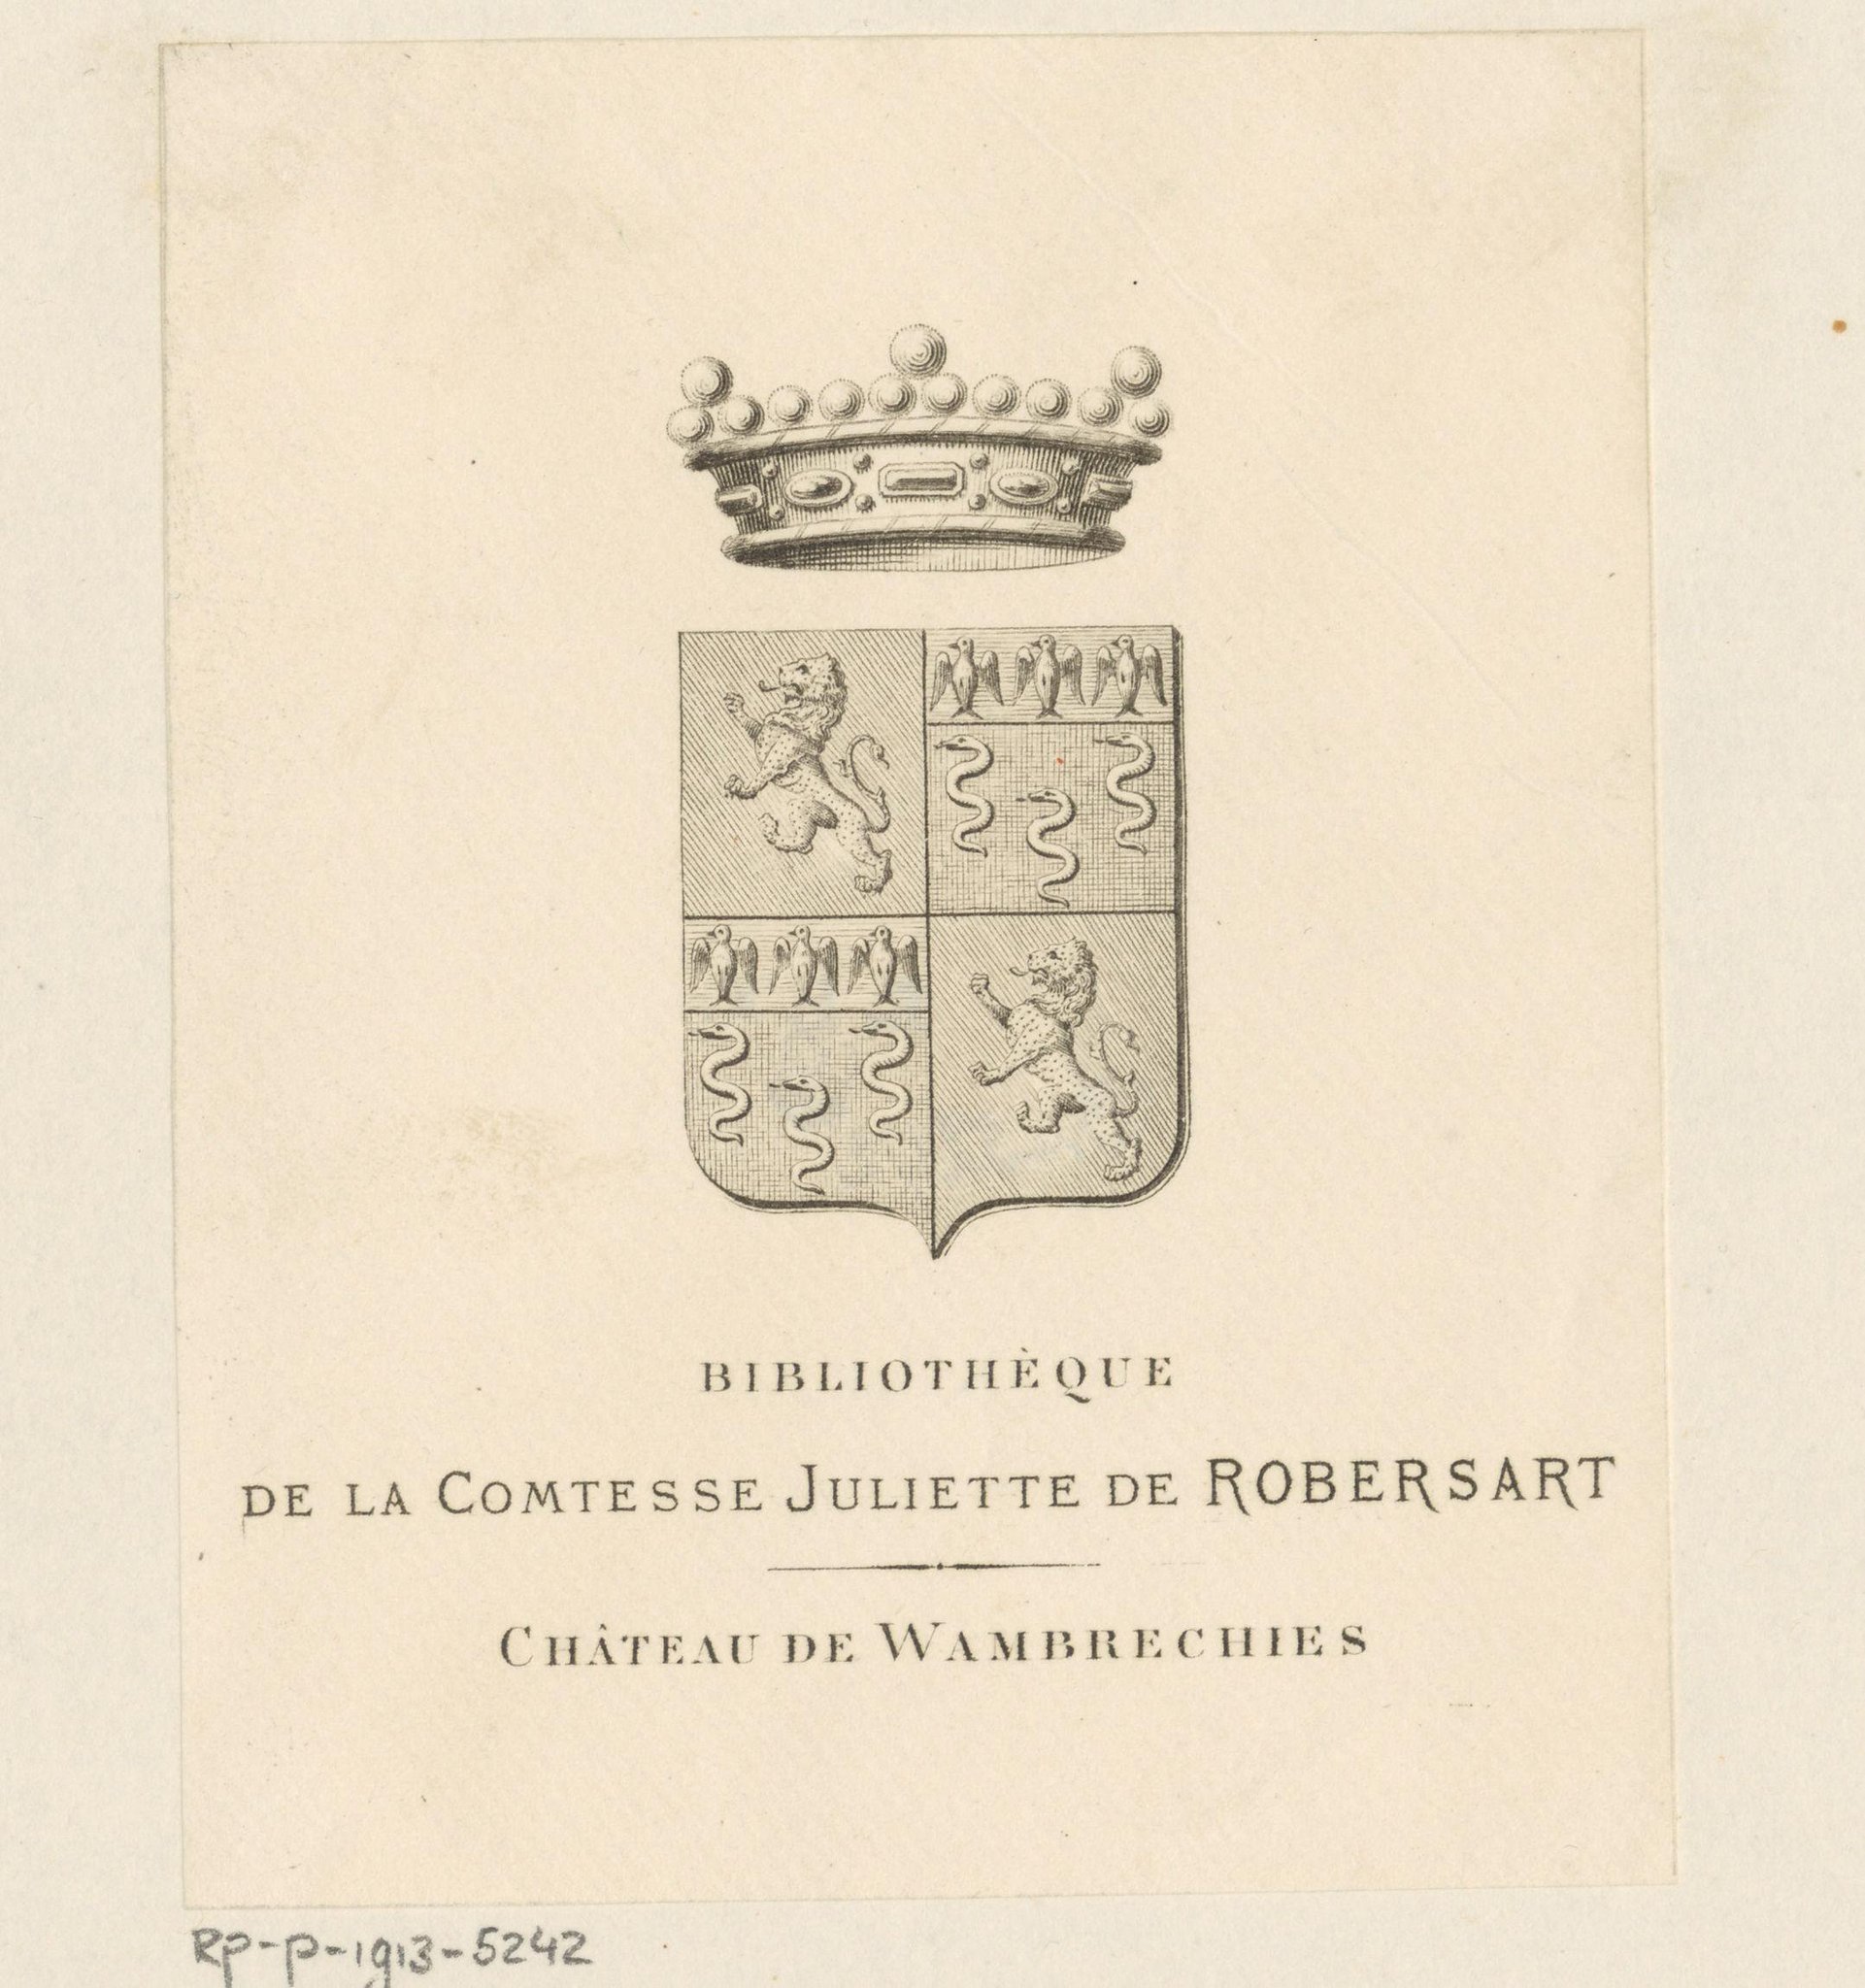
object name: bookplate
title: Ex libris van Bibliothèque de la Comtesse Juliette de Robersart, Château de Wambrechies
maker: Anonymous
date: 1834-1900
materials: paper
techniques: etching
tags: armorial bearing, heraldry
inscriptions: collector's mark: Lugt 2760, collector's mark: Lugt 2233